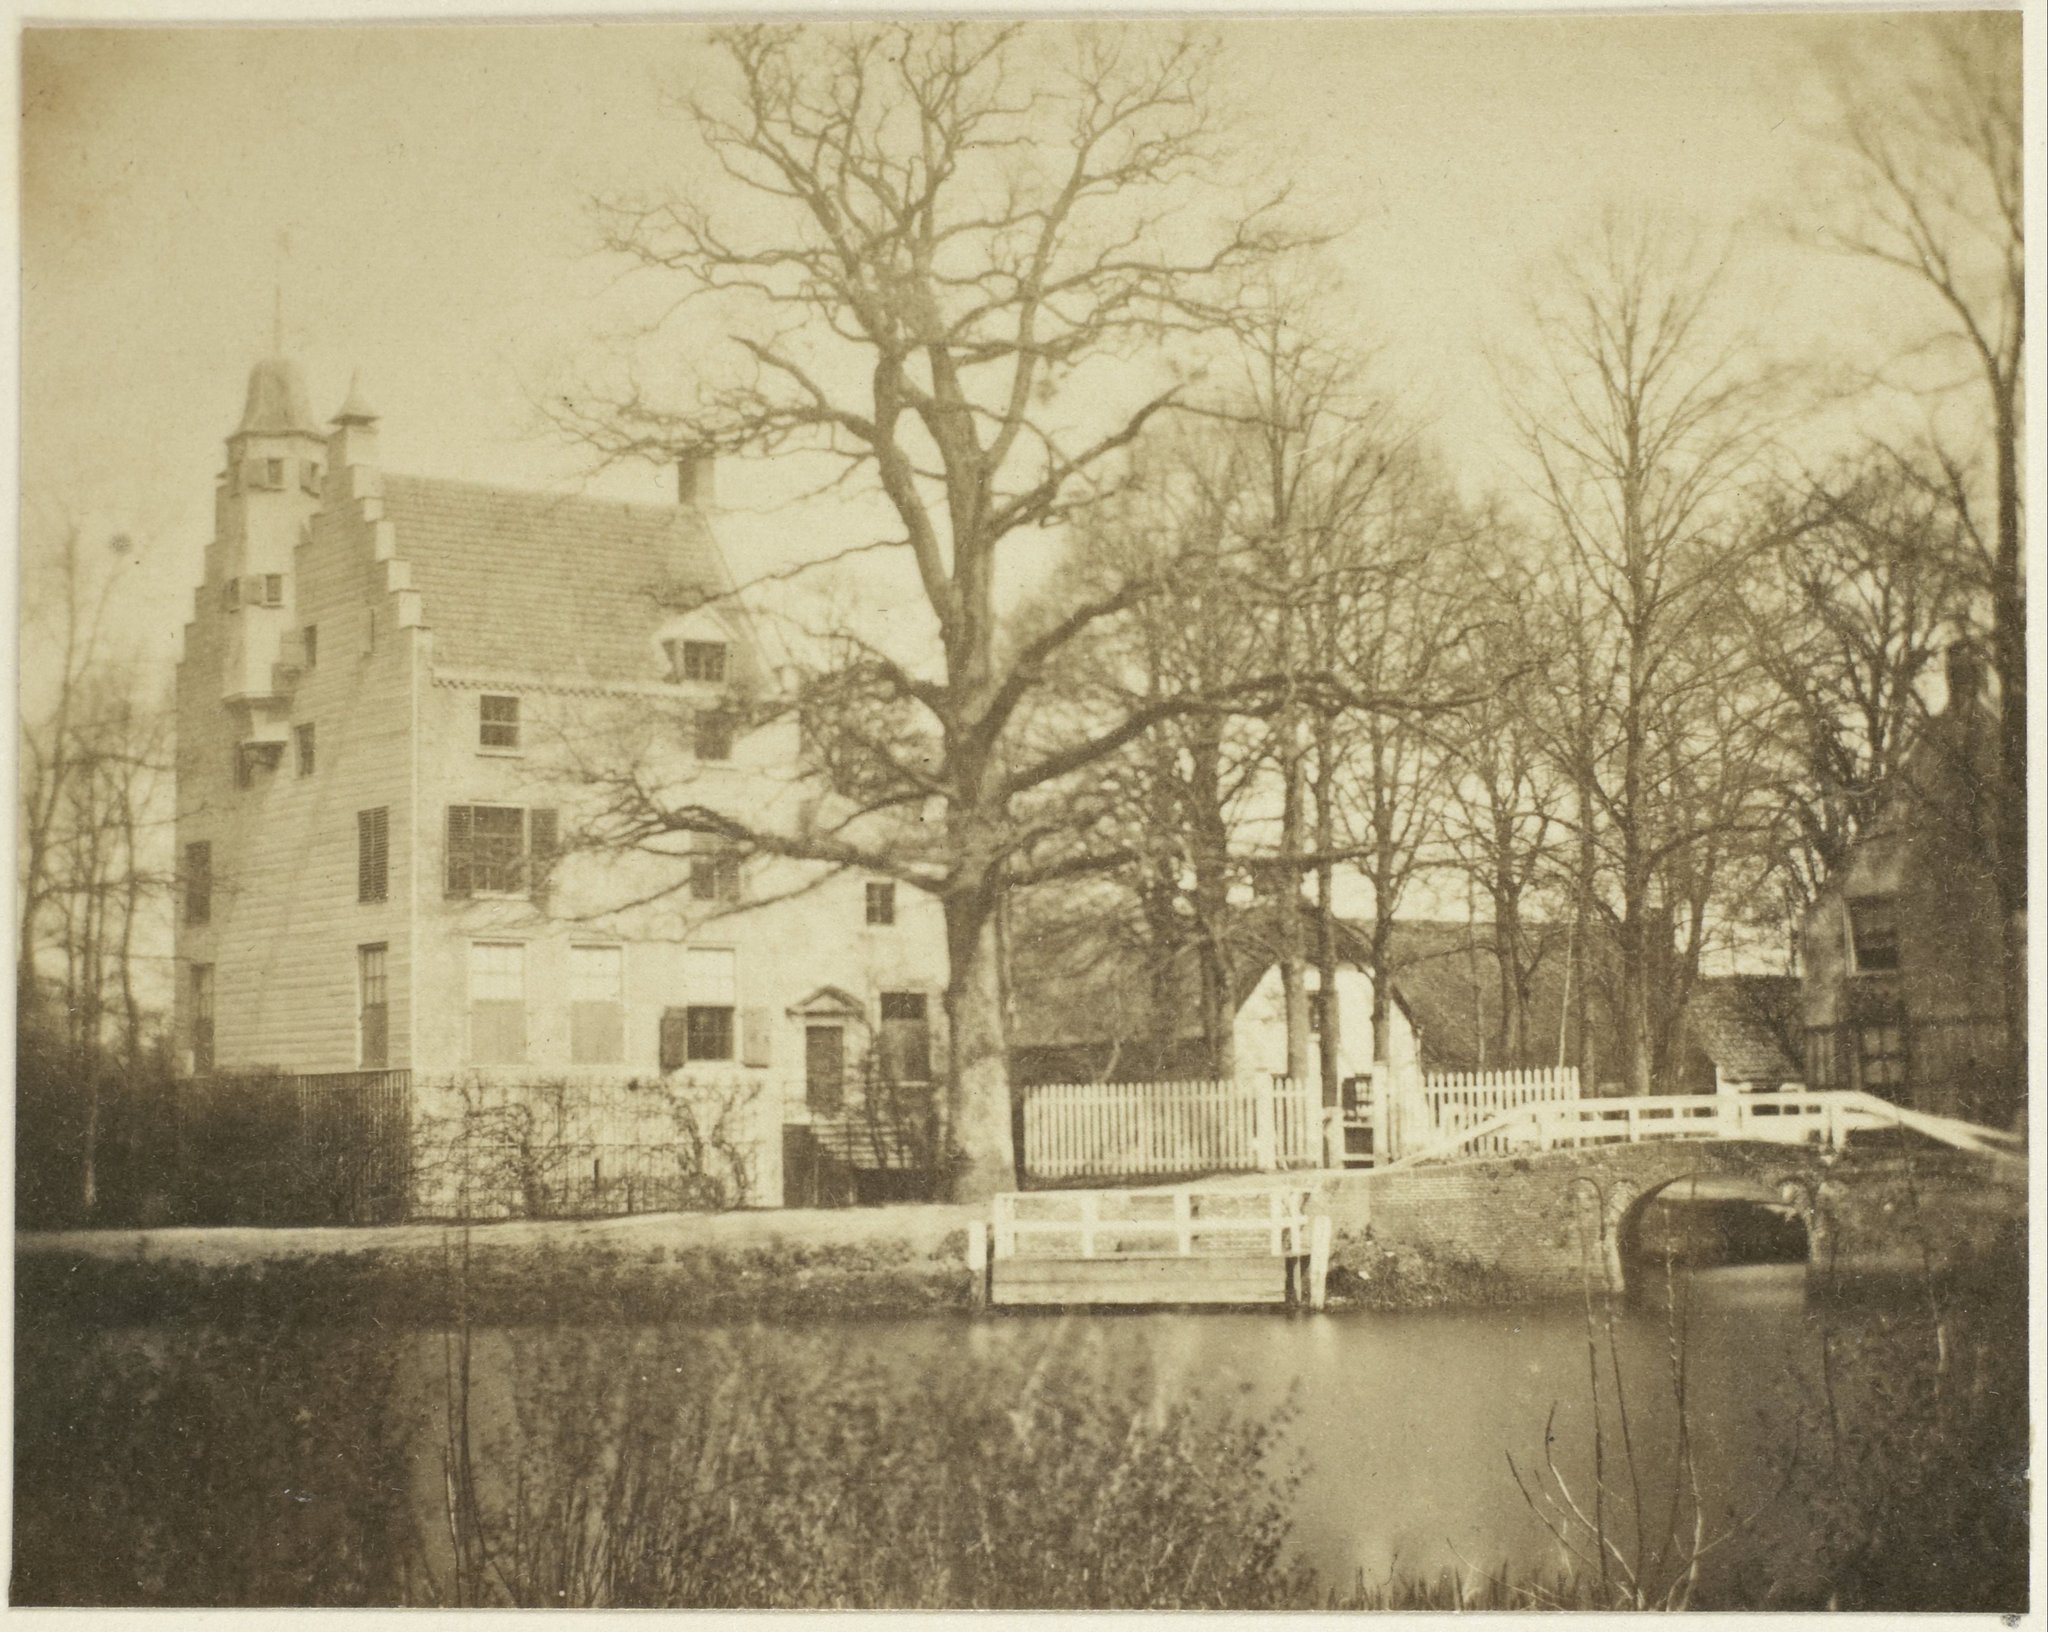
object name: photograph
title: Gezicht op huis Oudaan langs de Vecht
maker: eduard isaac asser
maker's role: amateurfotograaf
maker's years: 1809-1894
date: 1853-1854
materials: cardboard, paper, photographic support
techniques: salted paper print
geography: amsterdam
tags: breukelen